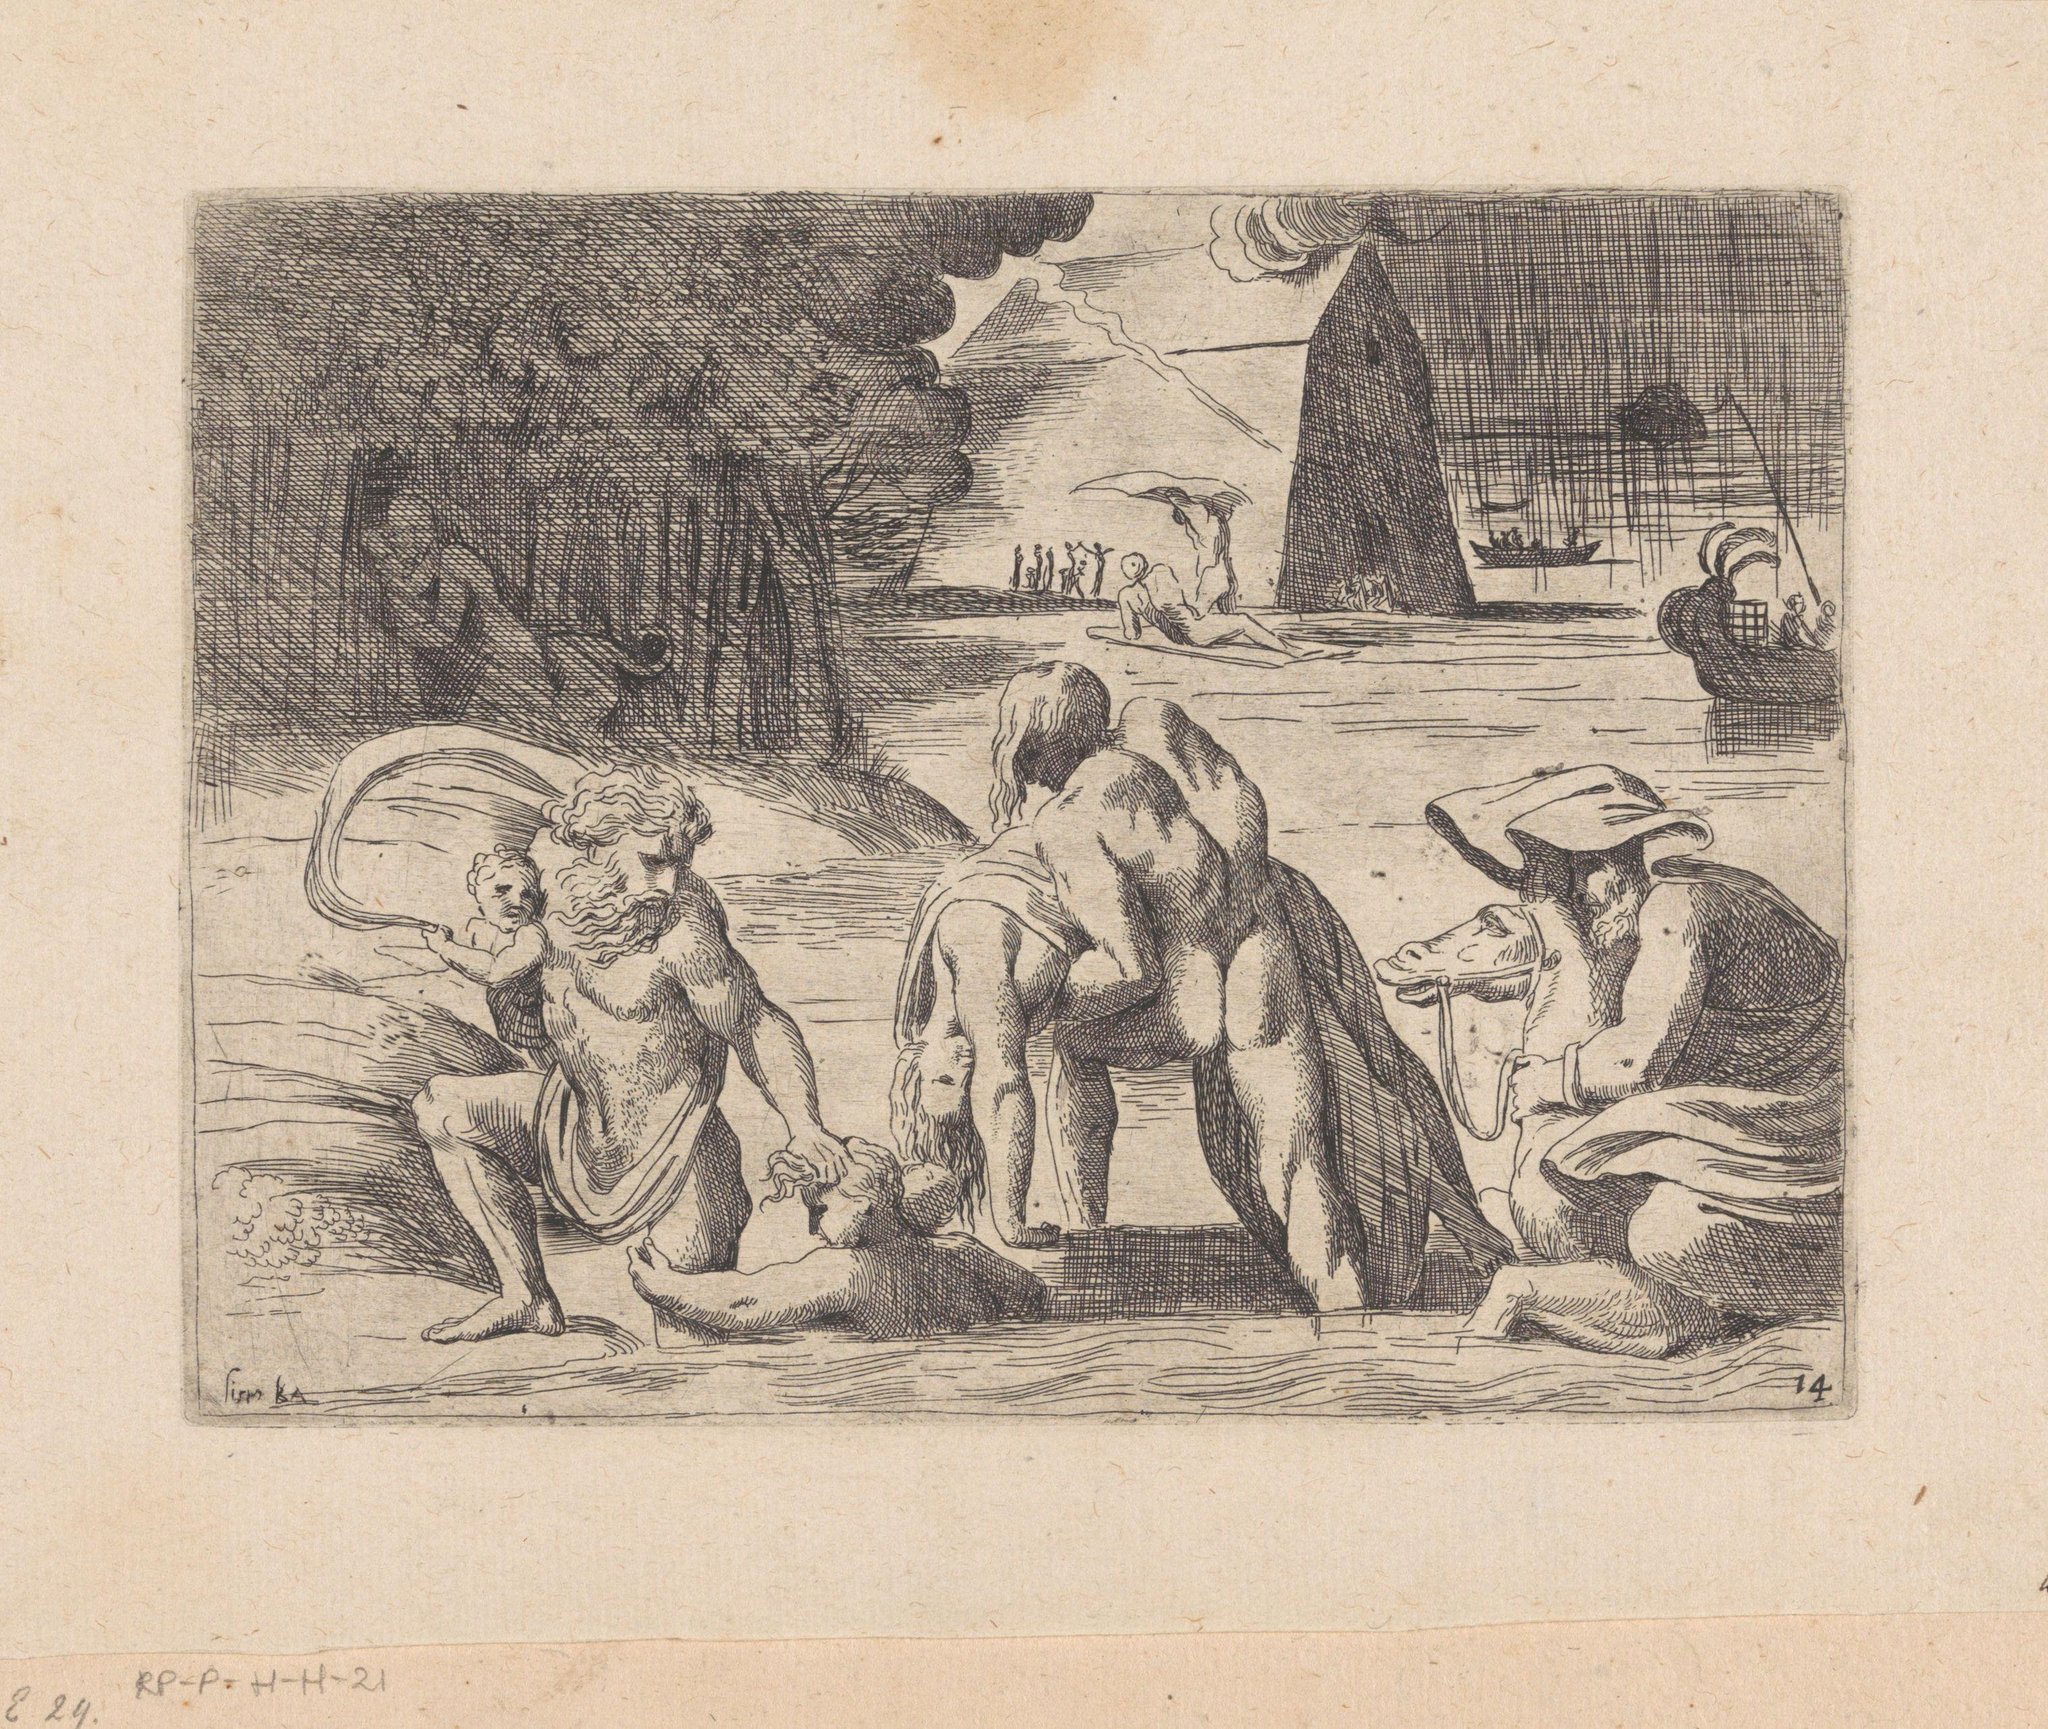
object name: print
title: Historia del Testamento Vecchio / Dipinta in Roma nel Vaticano da Raffaelle di Urbino (...)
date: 1607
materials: paper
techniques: etching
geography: rome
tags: the flood and destruction of mankind ~ story of noah (genesis 7:10 - 8:17)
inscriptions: collector's mark: Lugt 11, collector's mark: ‘Hinloopen’, number: ‘41’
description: Op een blad geplakt met rechtsboven handgeschreven in pen in bruin: 161. Prent uit een reeks van 54 genummerde prenten naar schilderingen in de Loggia van Rafael in het Vaticaan.